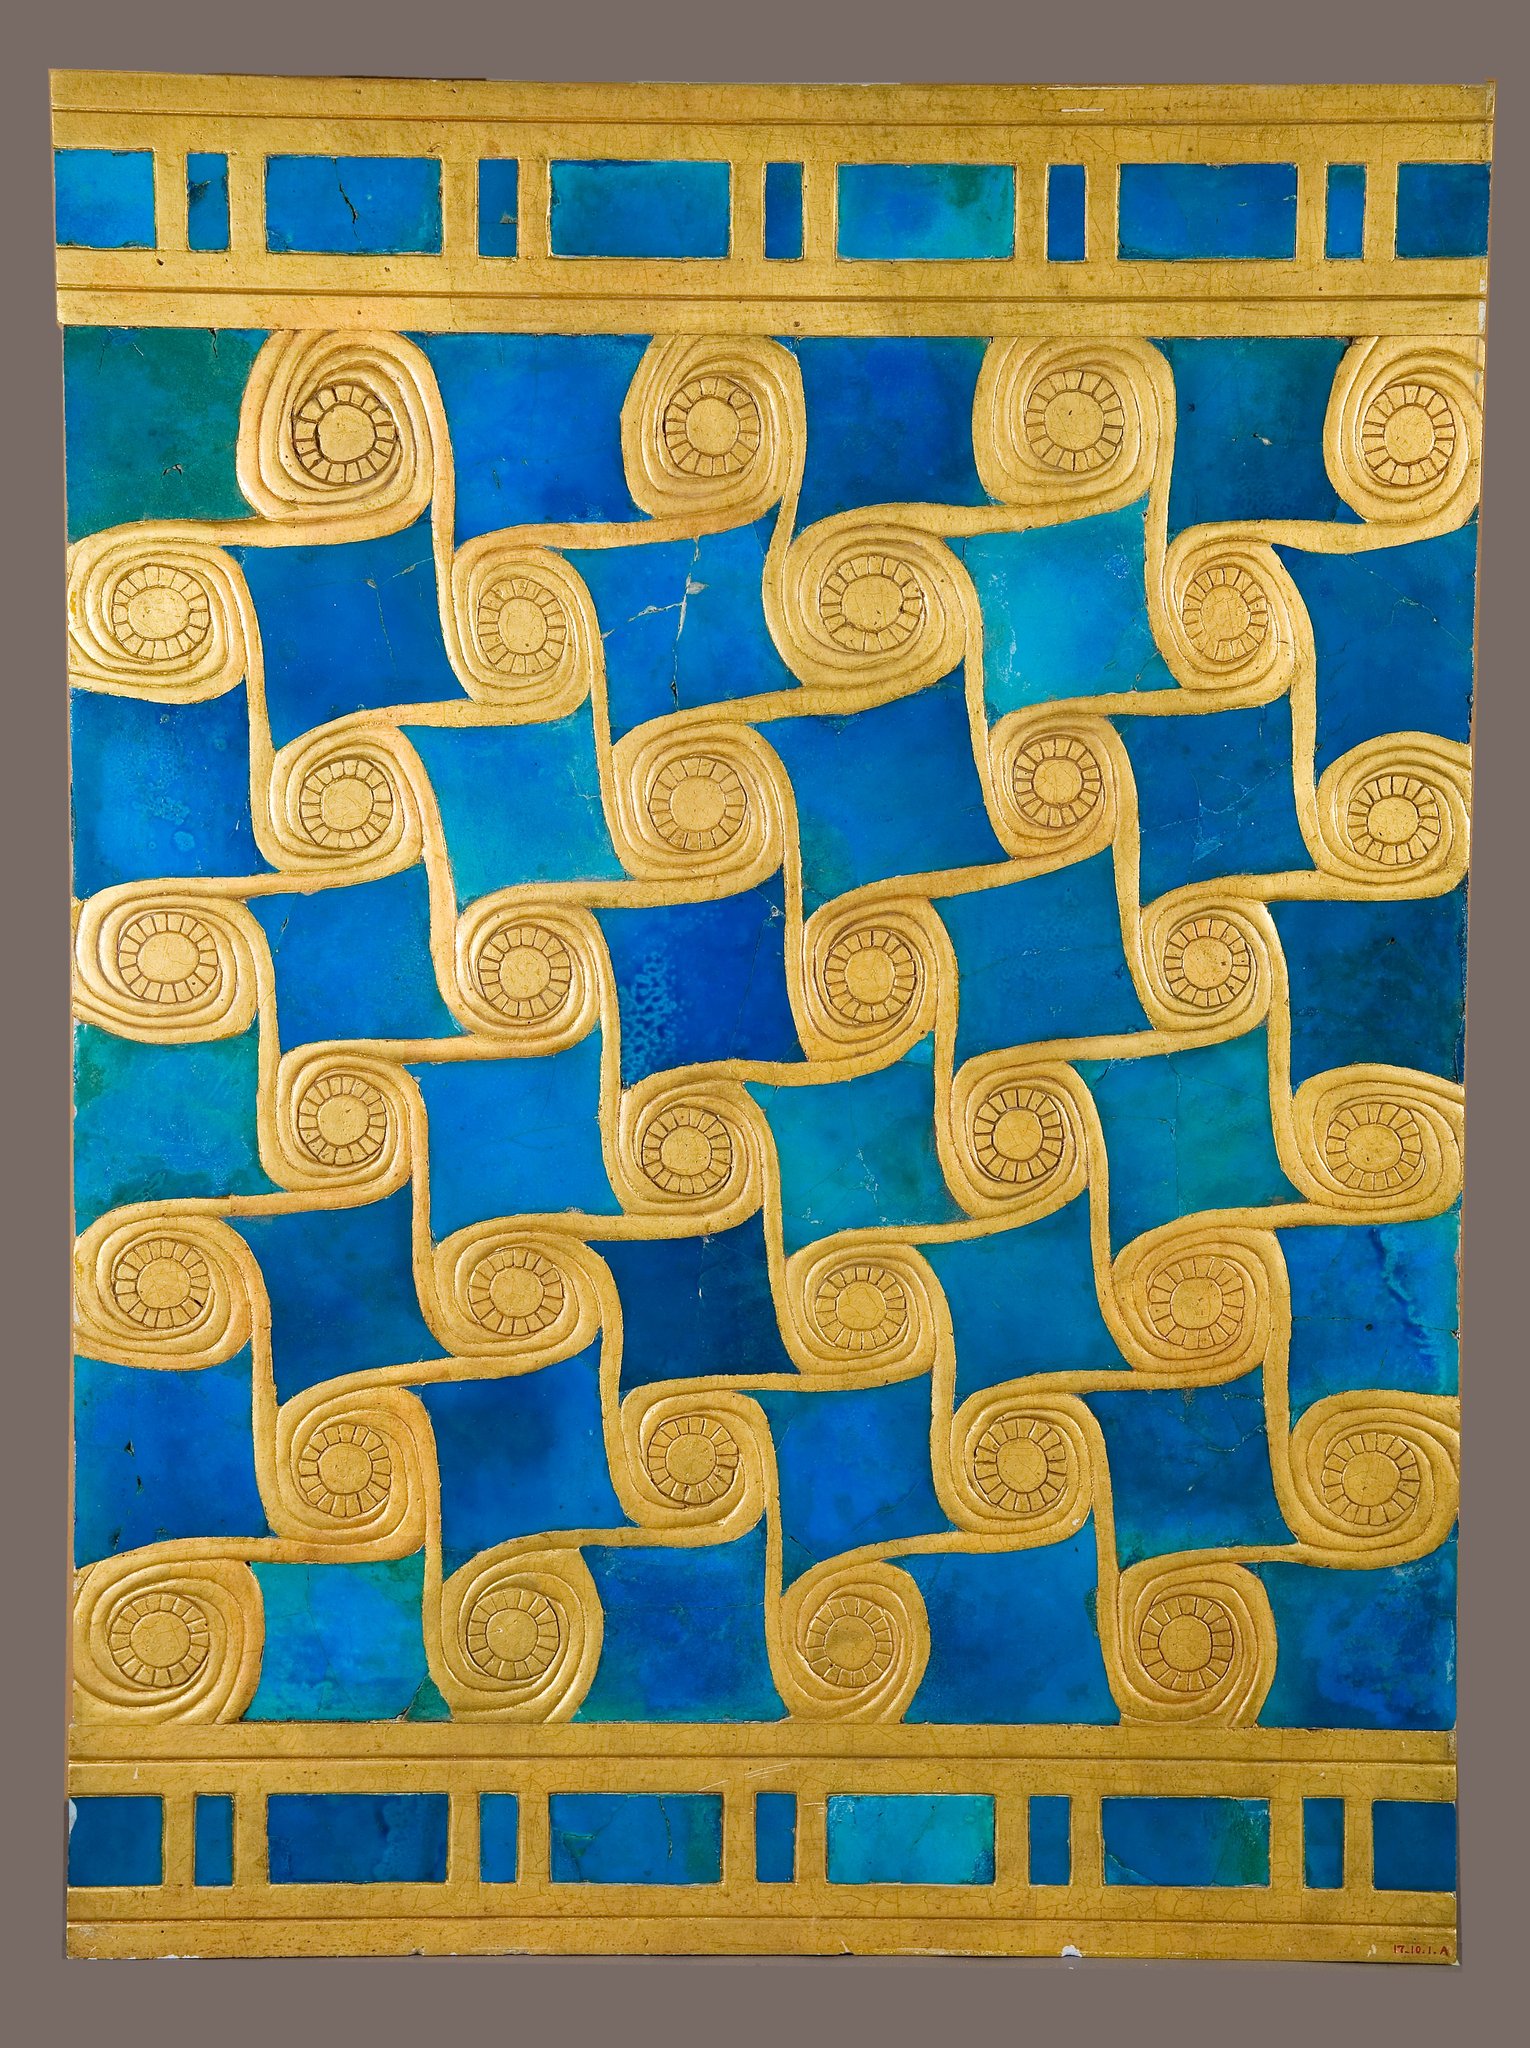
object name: tile, panel, spiral, faience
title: Reconstruction of Geometric Decoration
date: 1390-1352 BCE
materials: faience, gold paint, plaster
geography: egypt